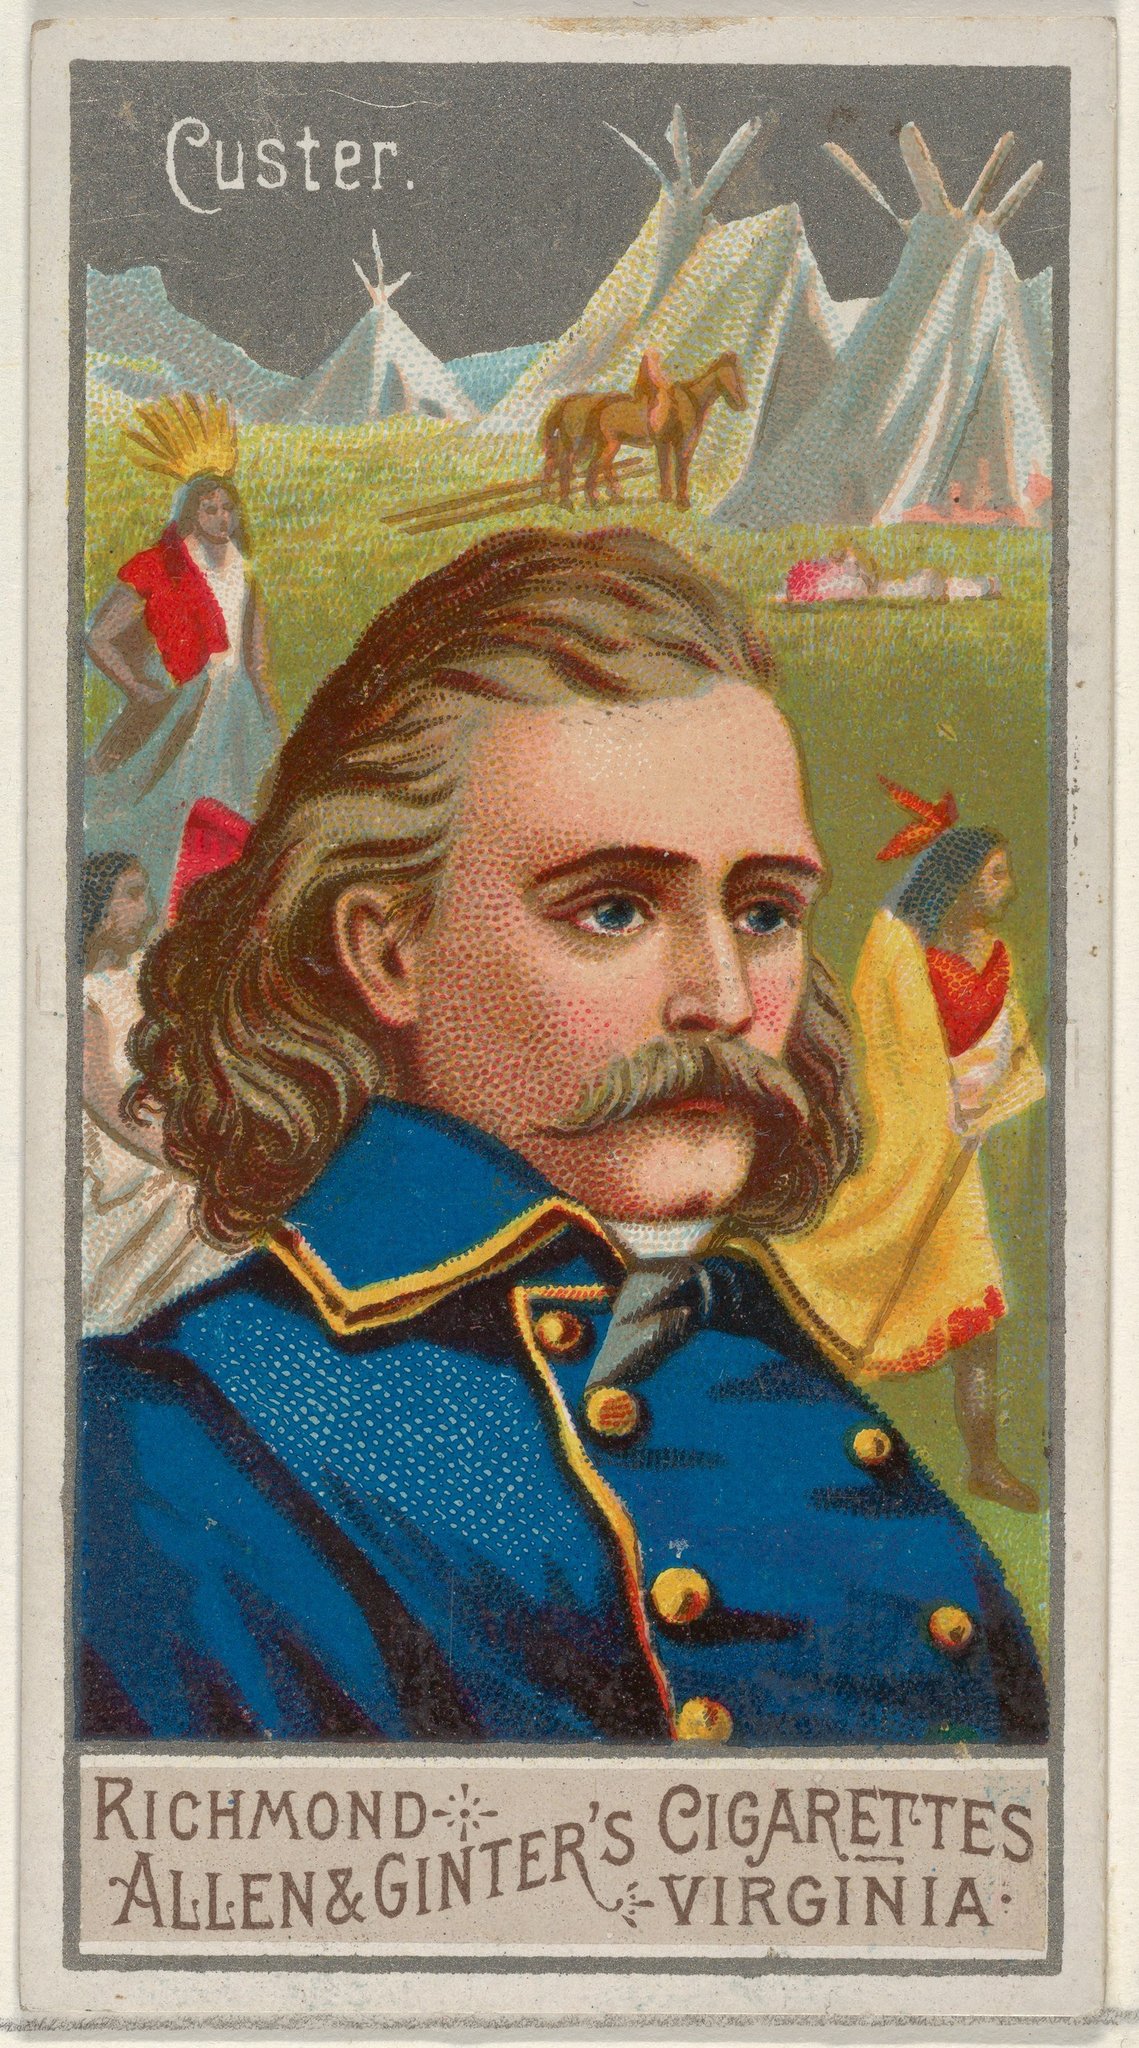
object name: print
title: George Armstrong Custer, from the Great Generals series (N15) for Allen & Ginter Cigarettes Brands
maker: allen & ginter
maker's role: publisher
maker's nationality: american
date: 1888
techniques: color lithograph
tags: men,generals